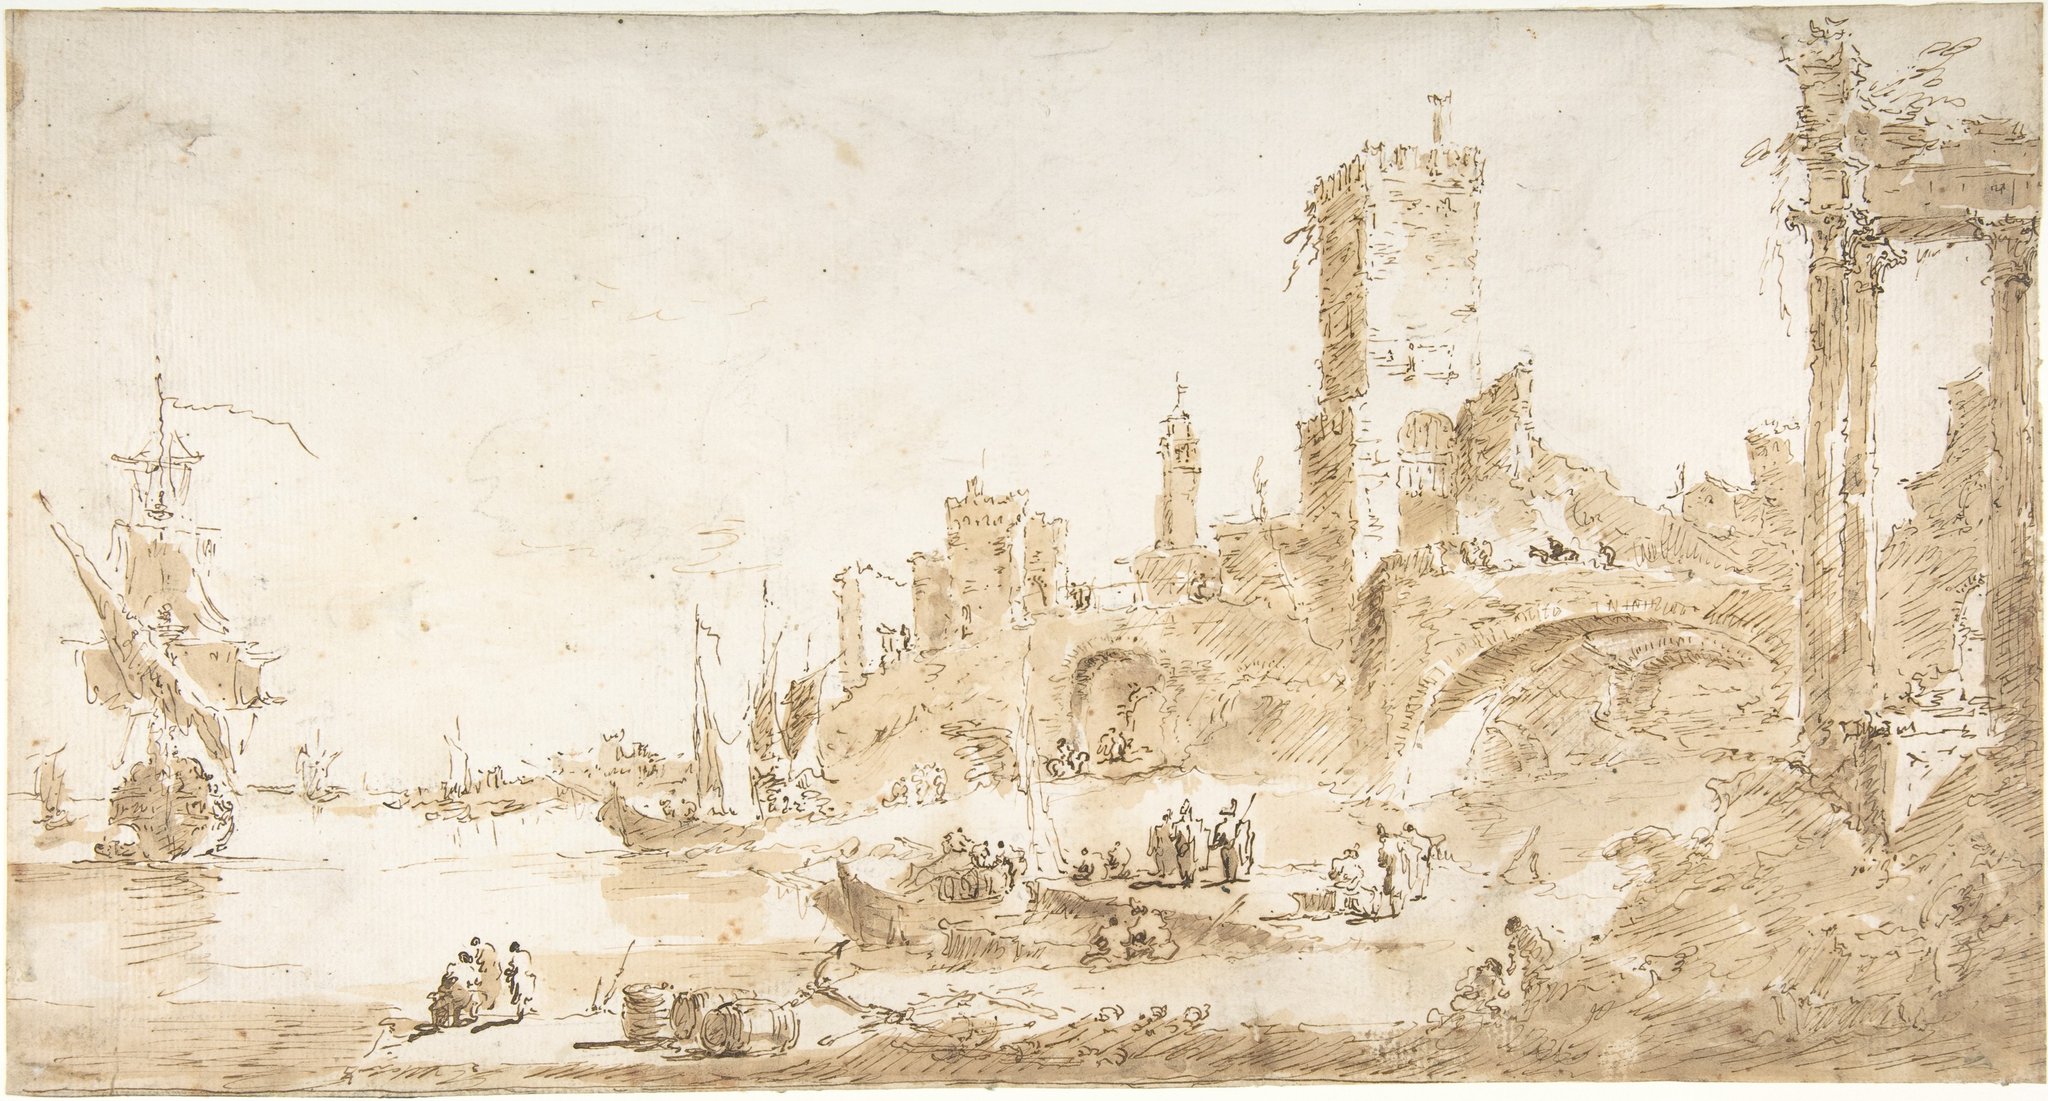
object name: drawing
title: Capriccio with a Seaport and Classical Ruins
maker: francesco guardi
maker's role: artist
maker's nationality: italian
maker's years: 1712-1793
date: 1712-1793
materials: chalk, ink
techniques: brush, pen, wash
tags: ruins,boats